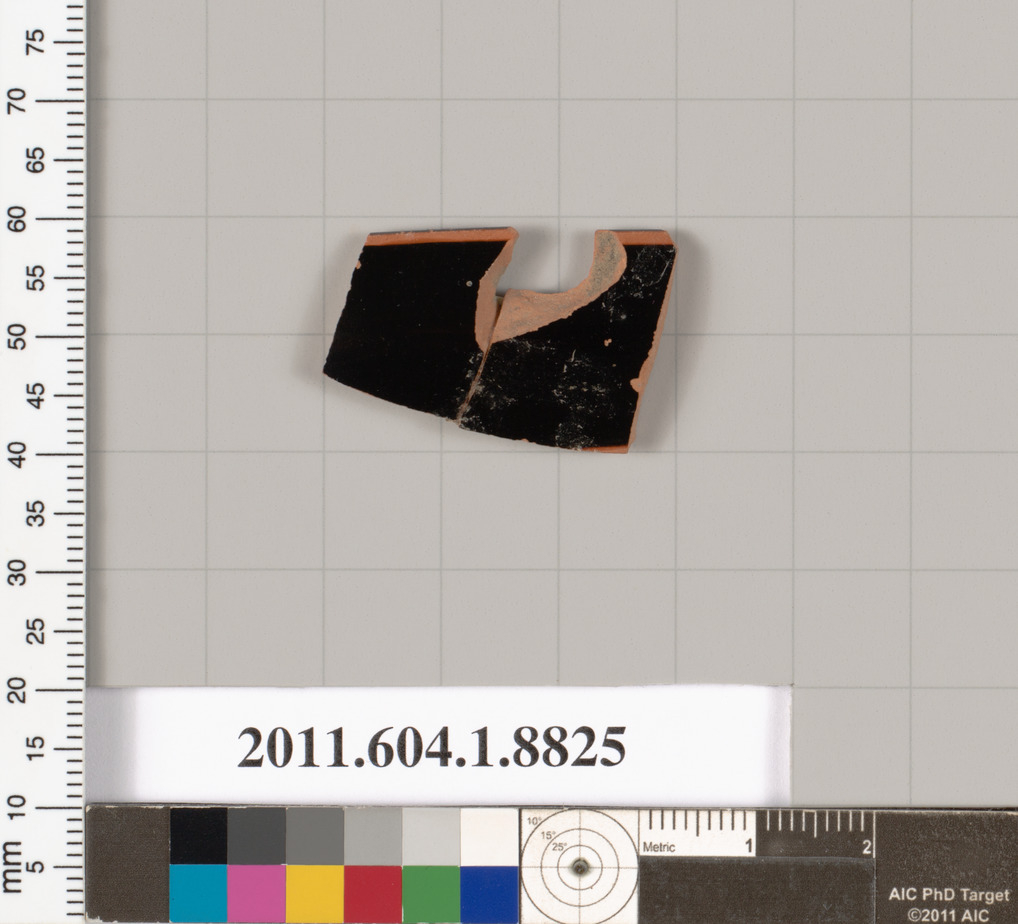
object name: kylix fragment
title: Terracotta rim fragment of a kylix (drinking cup)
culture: greek, attic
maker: douris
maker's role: artist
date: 490-480 BCE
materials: terracotta